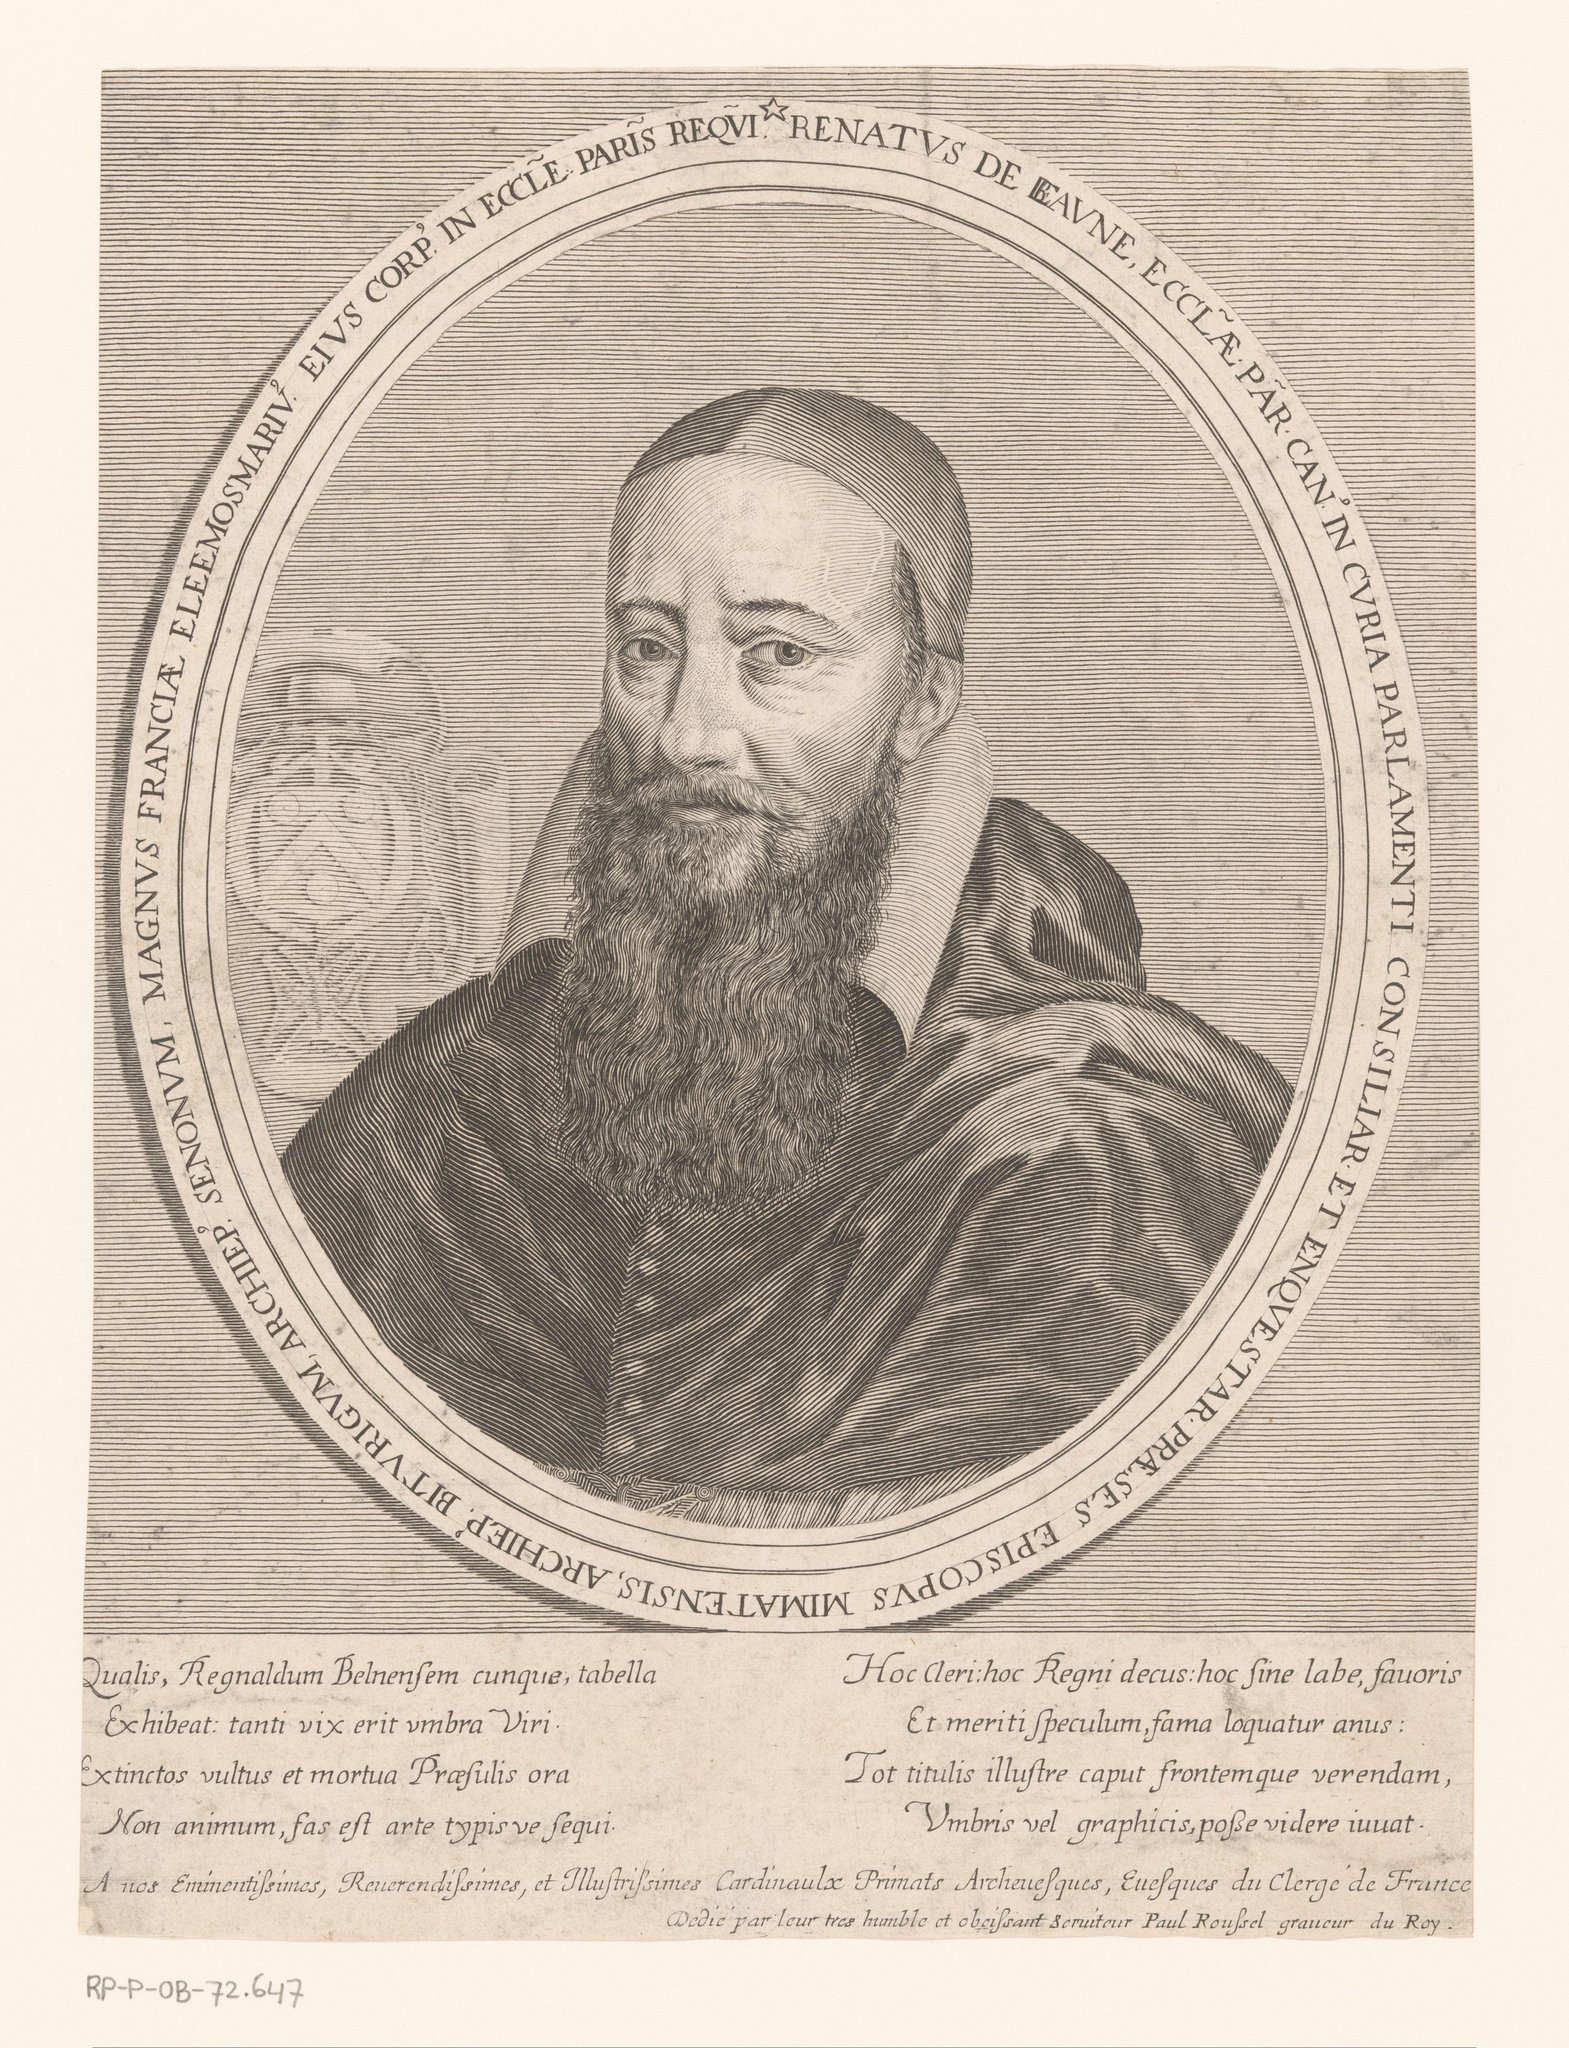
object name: print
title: Portret van Regnaldus Belnensis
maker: paul roussel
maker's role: print maker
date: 1605-1647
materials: paper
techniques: engraving, etching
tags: clergyman, hierarchy of jurisdiction ~ roman catholic church, historical persons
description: Opgedragen aan alle hoge geestelijken van Frankrijk.